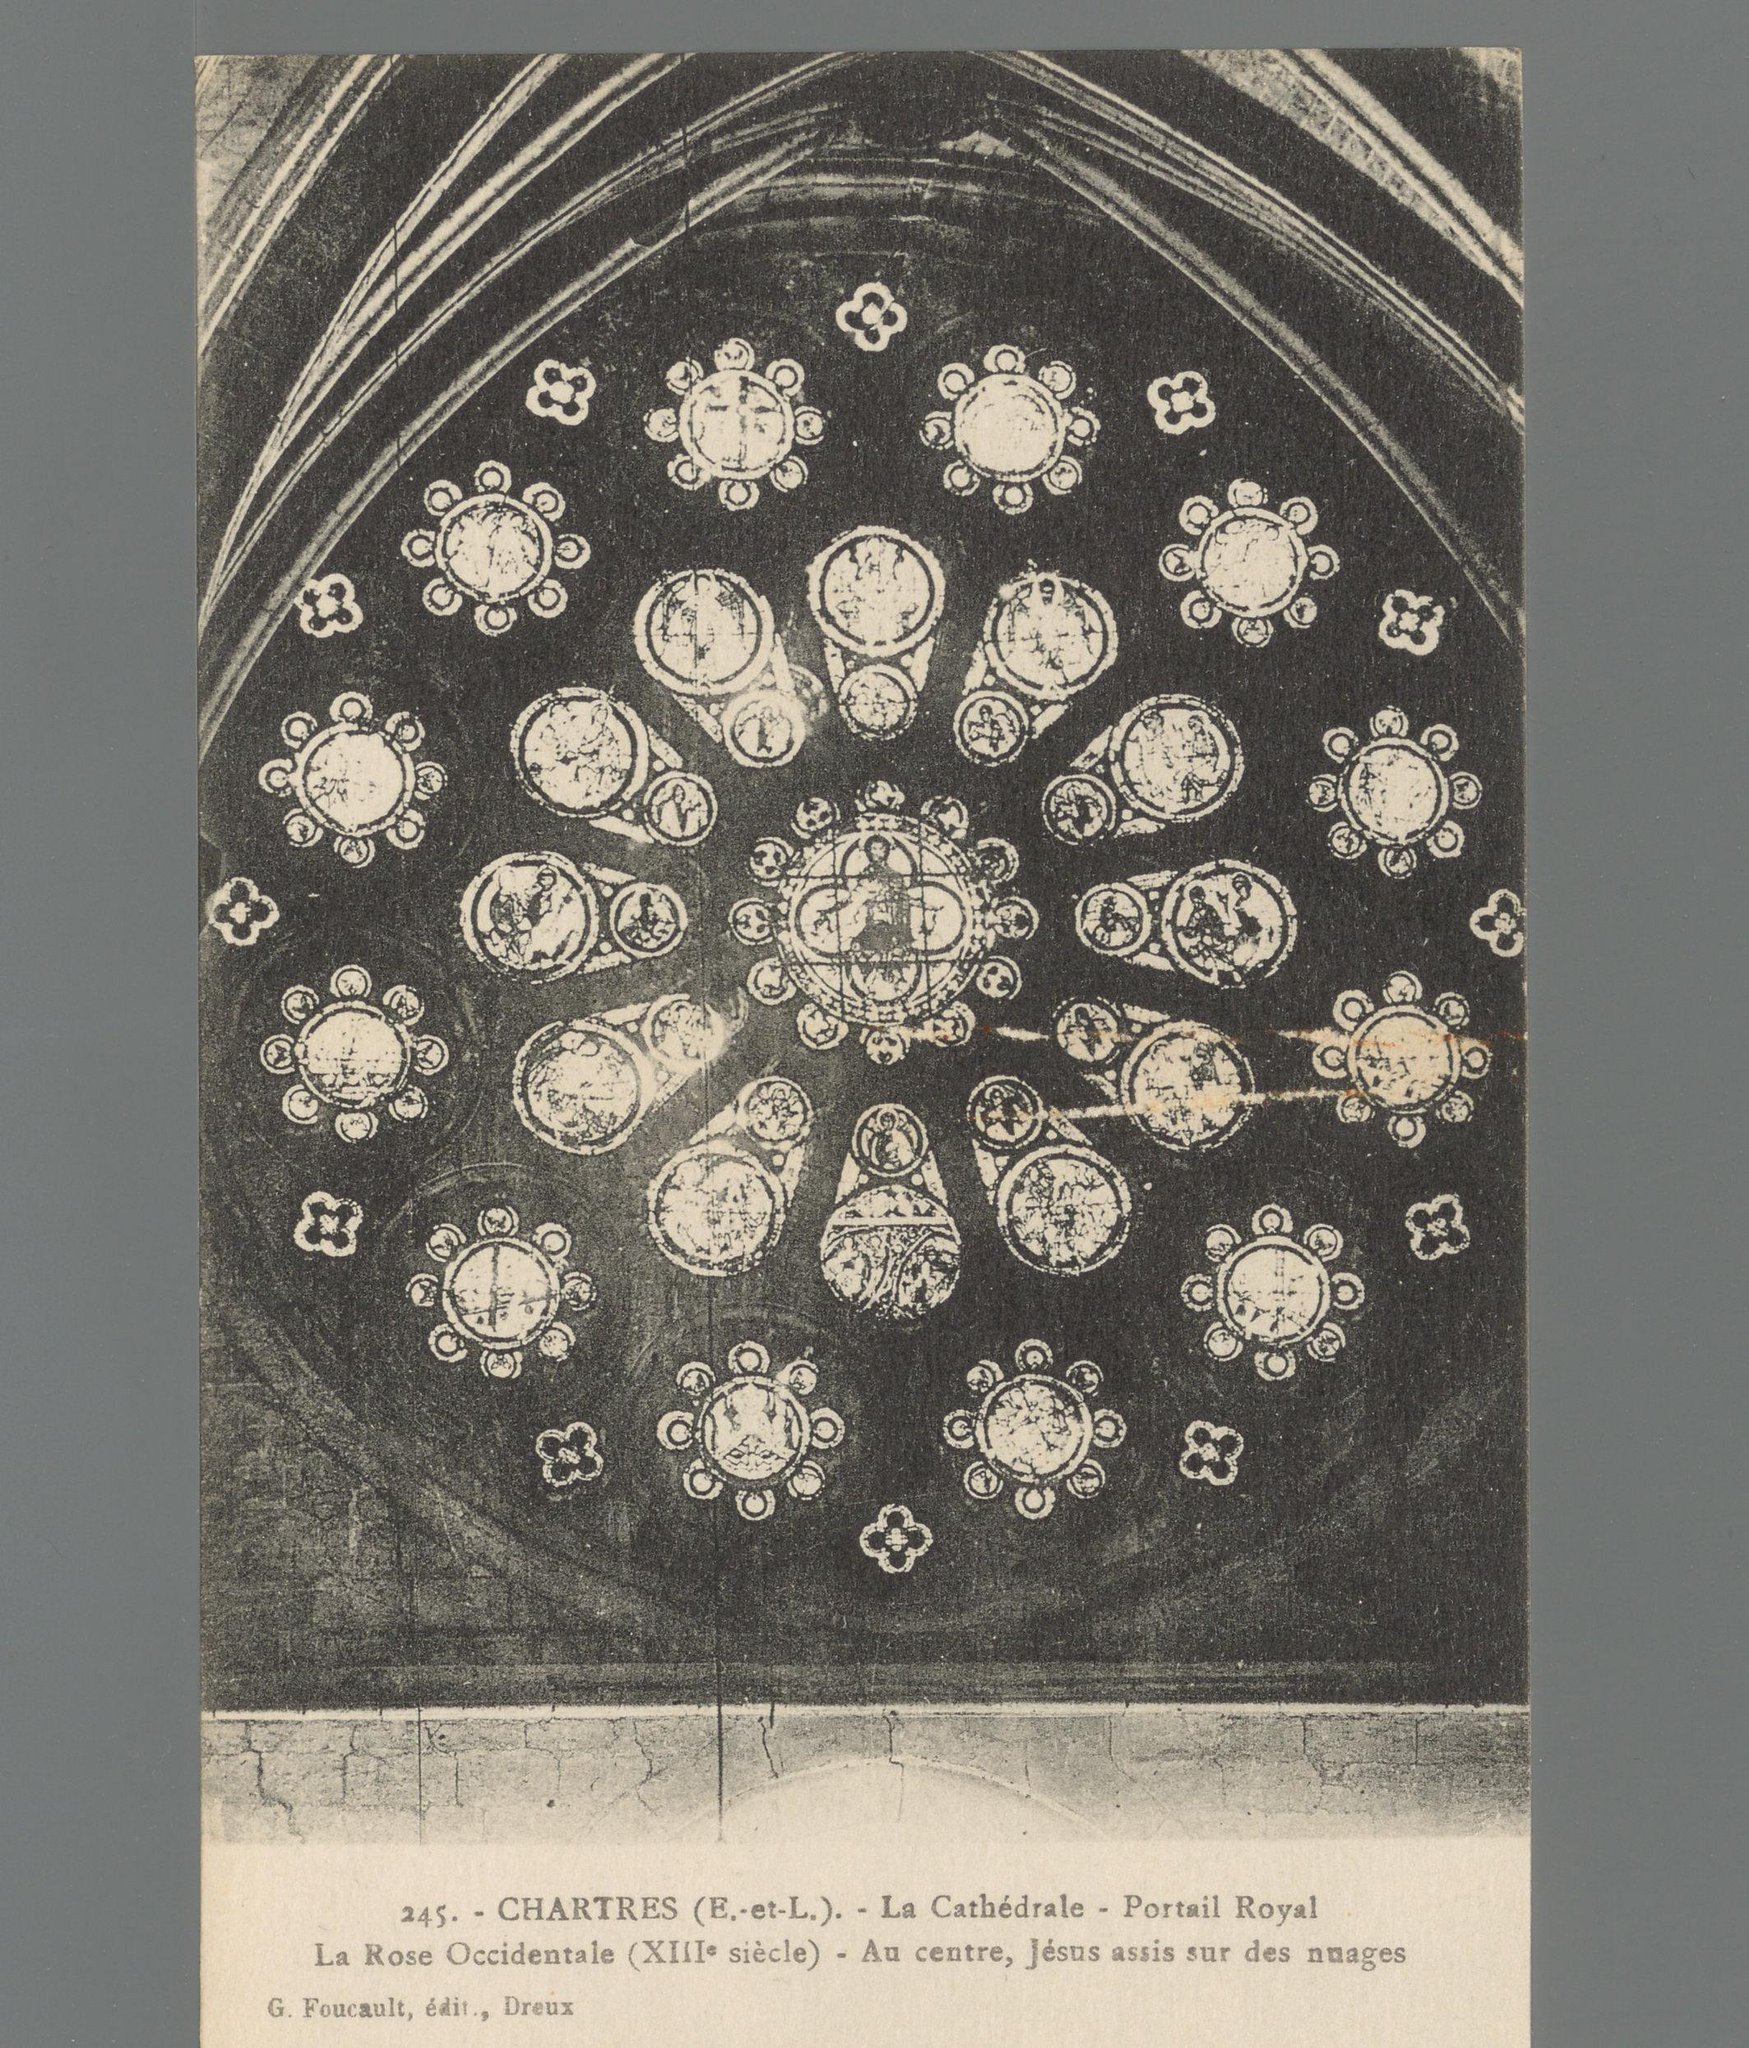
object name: photomechanical print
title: Chartres (E. et-L).- La Cathédrale - Portail Royal. La Rose Occidentale (XIIIe siècle) - au centre, Jésus assis sur des nuages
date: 1903-1930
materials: cardboard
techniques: photograph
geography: chartres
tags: church-window, e.g. rose-window, interior of church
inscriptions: collector's mark: ‘AFE v S’